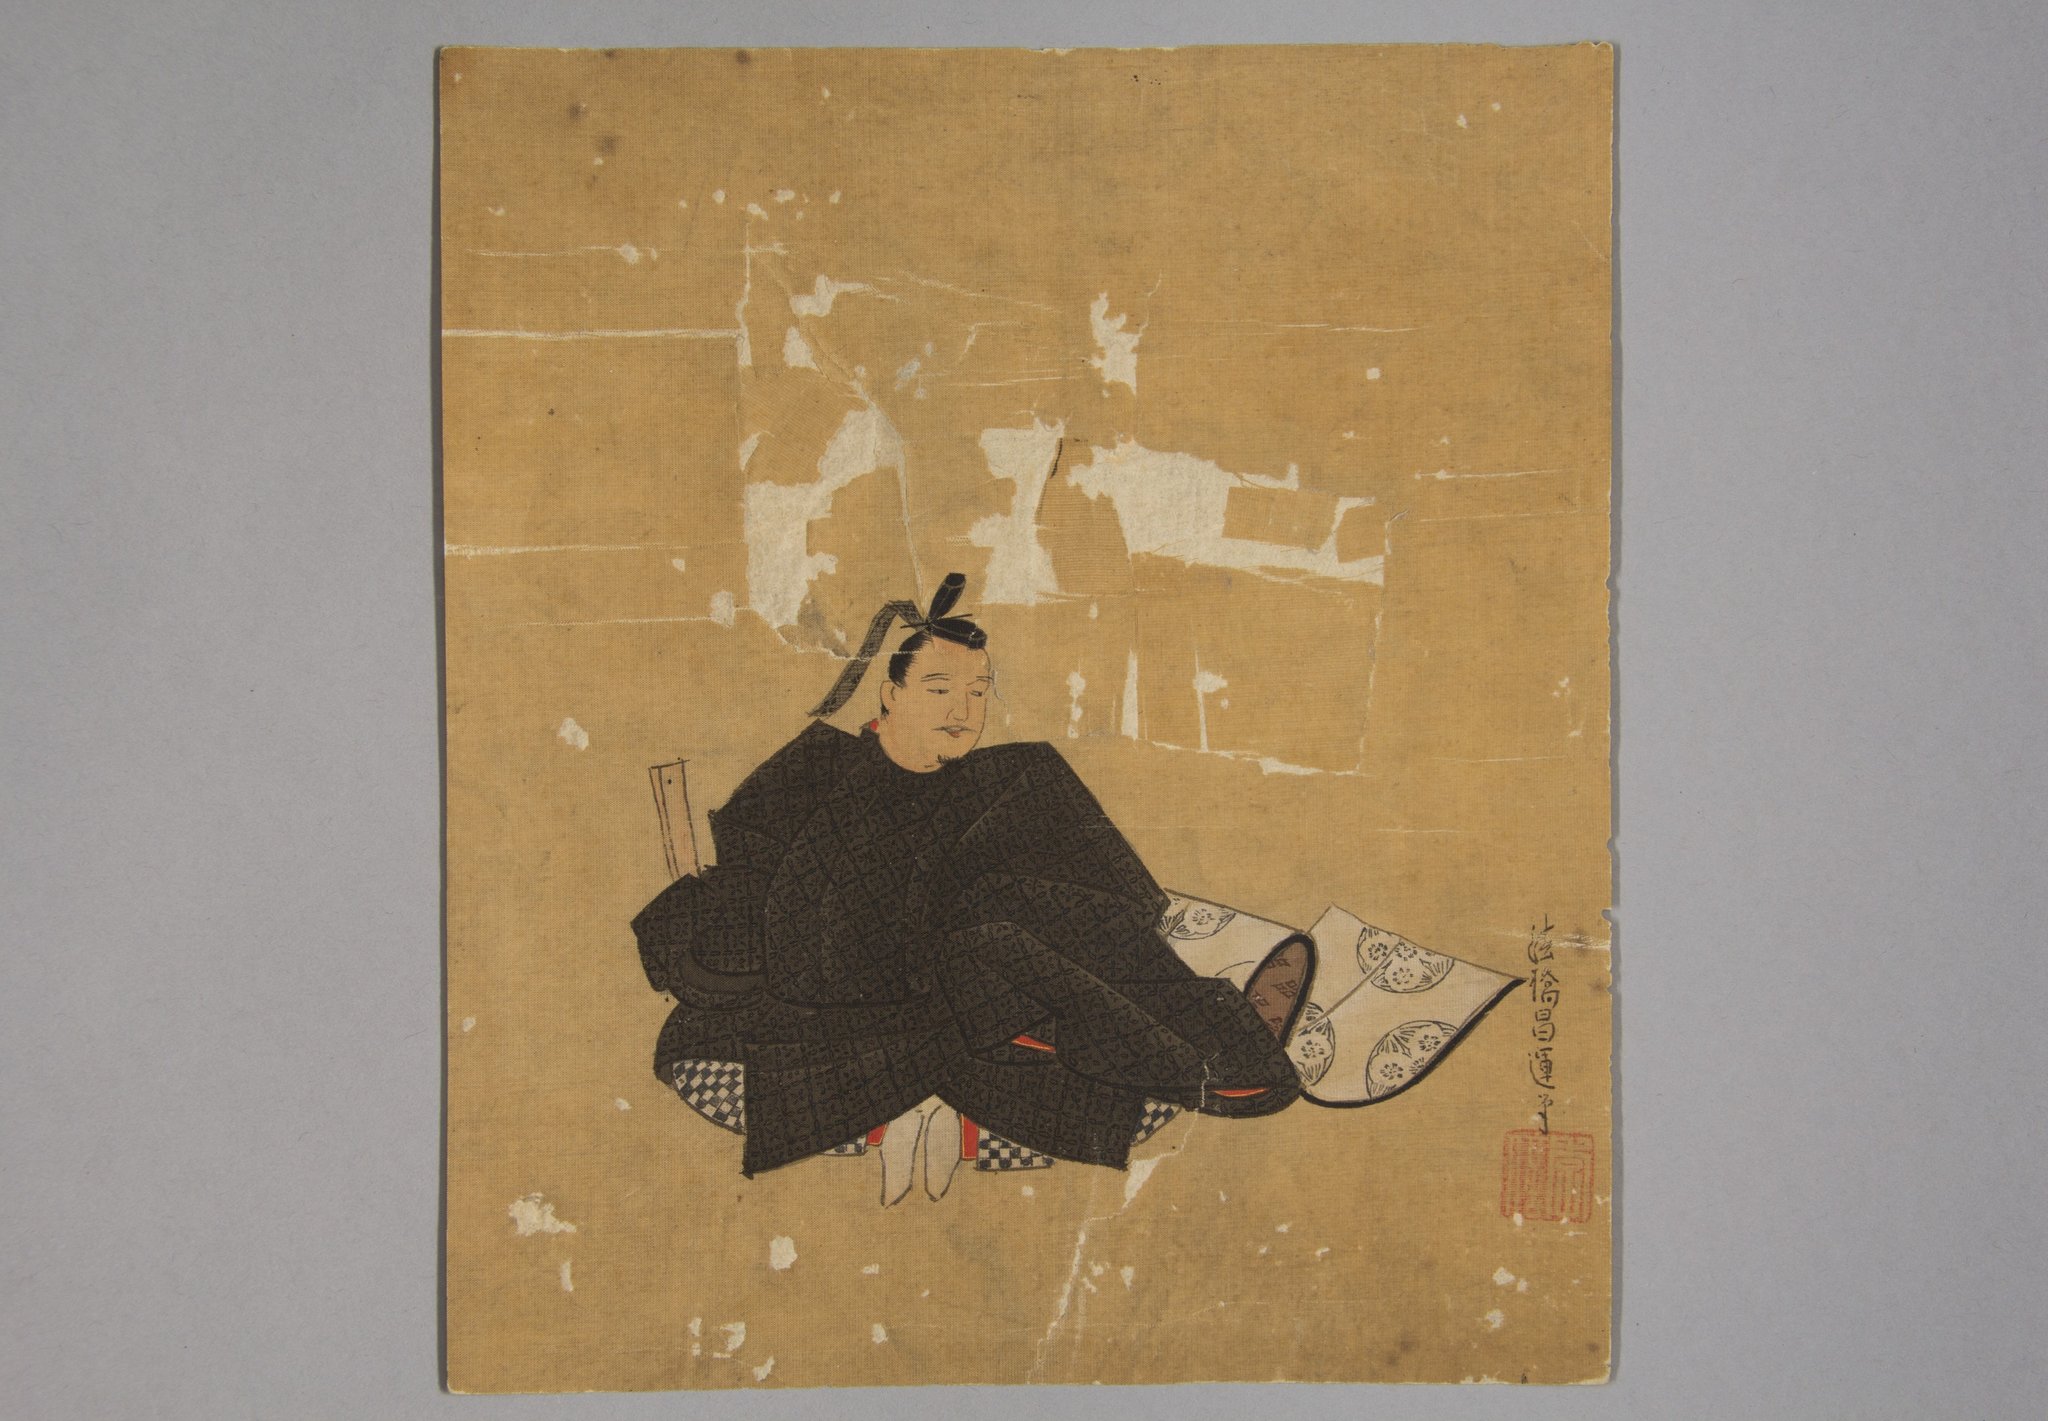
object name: painting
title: Immortal Poet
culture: japanese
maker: kano shōun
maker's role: artist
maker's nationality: japanese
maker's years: 1637-1702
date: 1601-1700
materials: ink, silk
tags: men,poets